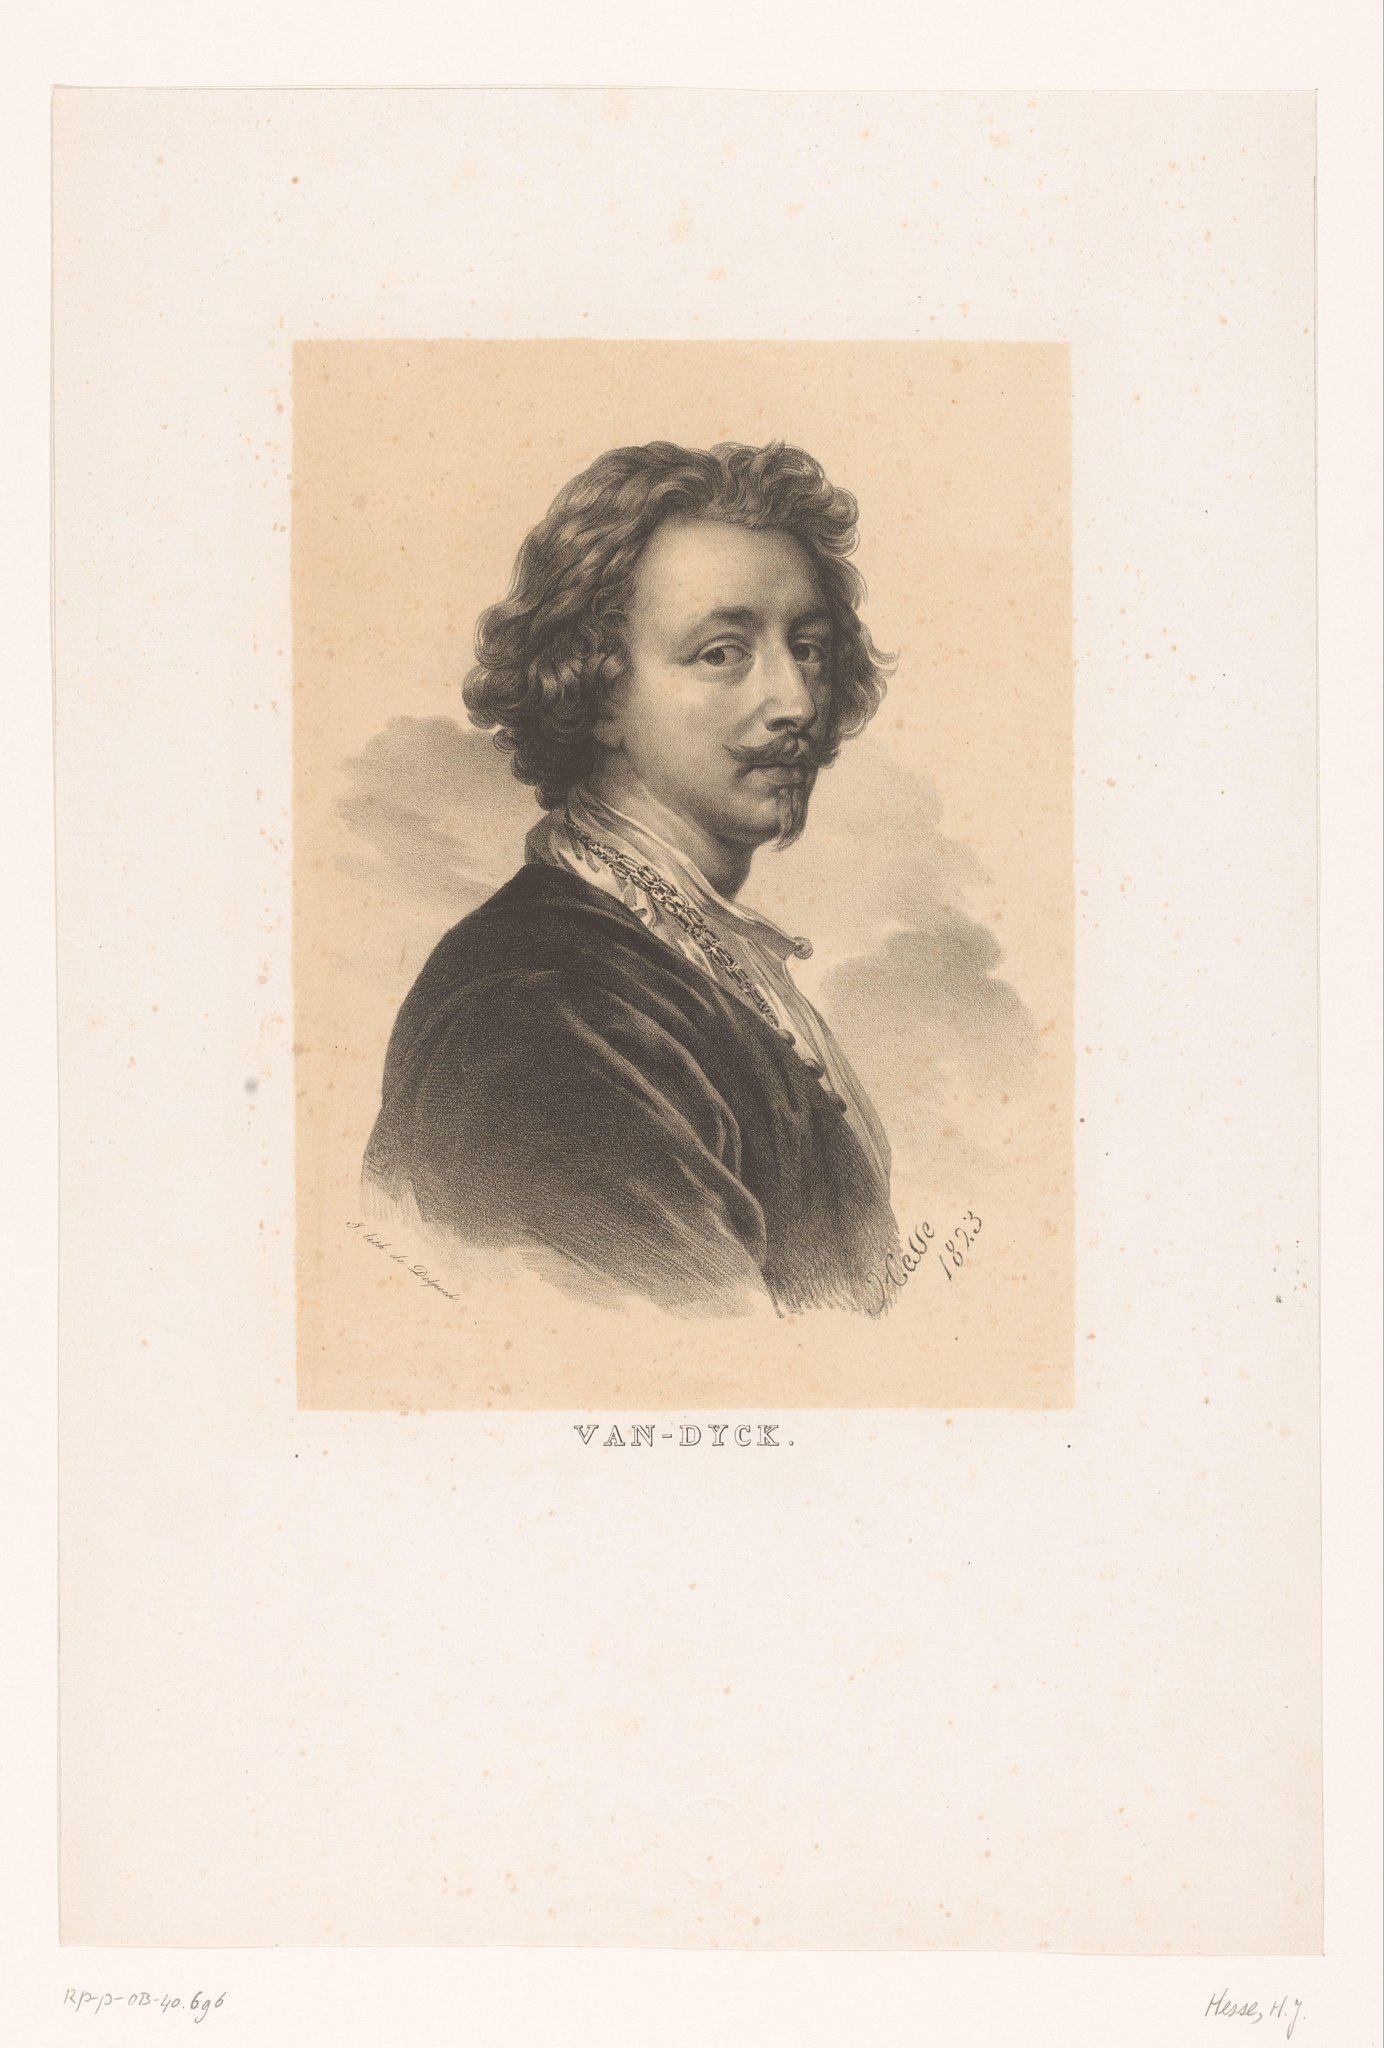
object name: print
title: Van-Dyck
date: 1823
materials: paper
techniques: lithograph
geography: paris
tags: antwerp, london, painter, print maker, draughtsman, anthony van dyck, historical persons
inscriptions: check stamp: ‘CN (?)’